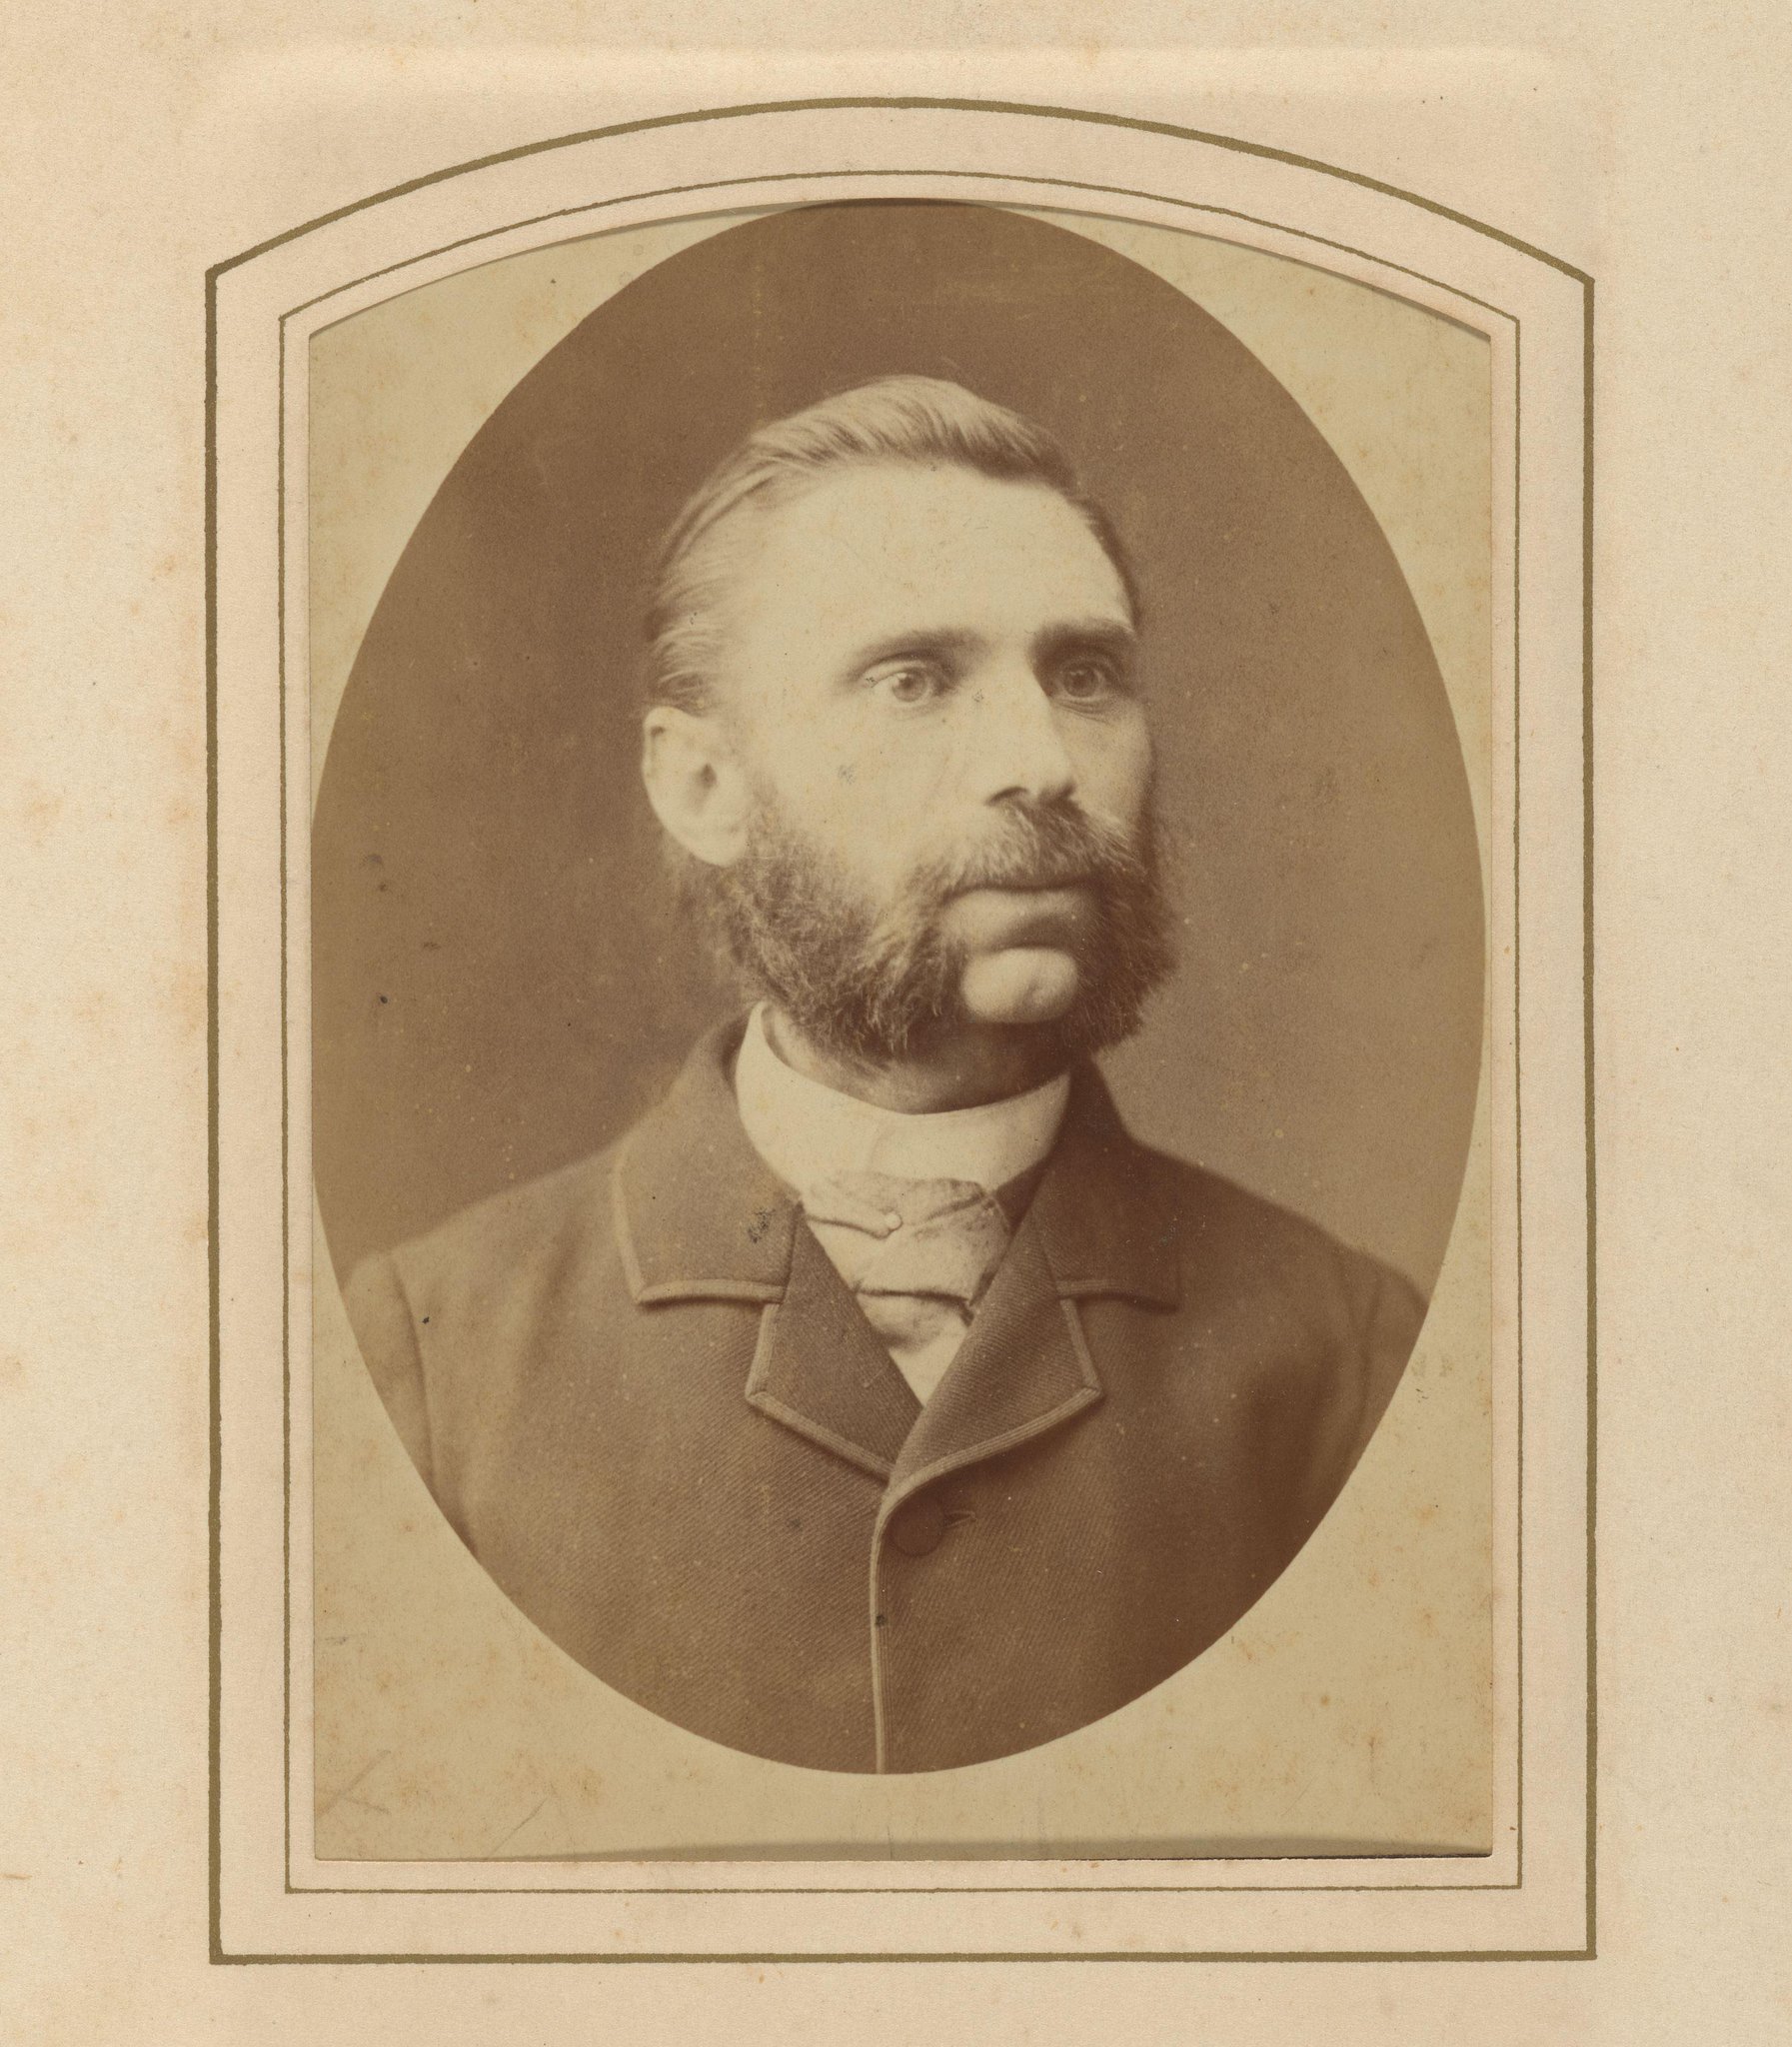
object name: cabinet photograph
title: Portret van een man, aangeduid als Pa Heijnen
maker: pieter wilhelmus roemer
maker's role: fotograaf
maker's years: 1838-1924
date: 1864-1910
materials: cardboard, photographic support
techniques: albumen print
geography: the hague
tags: historical persons, beard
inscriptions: inscription: ‘Photographie Artistique/ van/ P. W. Roemer/ Passage No 22/ bij de Spuistraat./ S'Gravenhage./ Specialiteit van Vergrootingen./ De plaat blijft ter nabestelling bewaard.’, annotation: ‘Pa Heijnen’